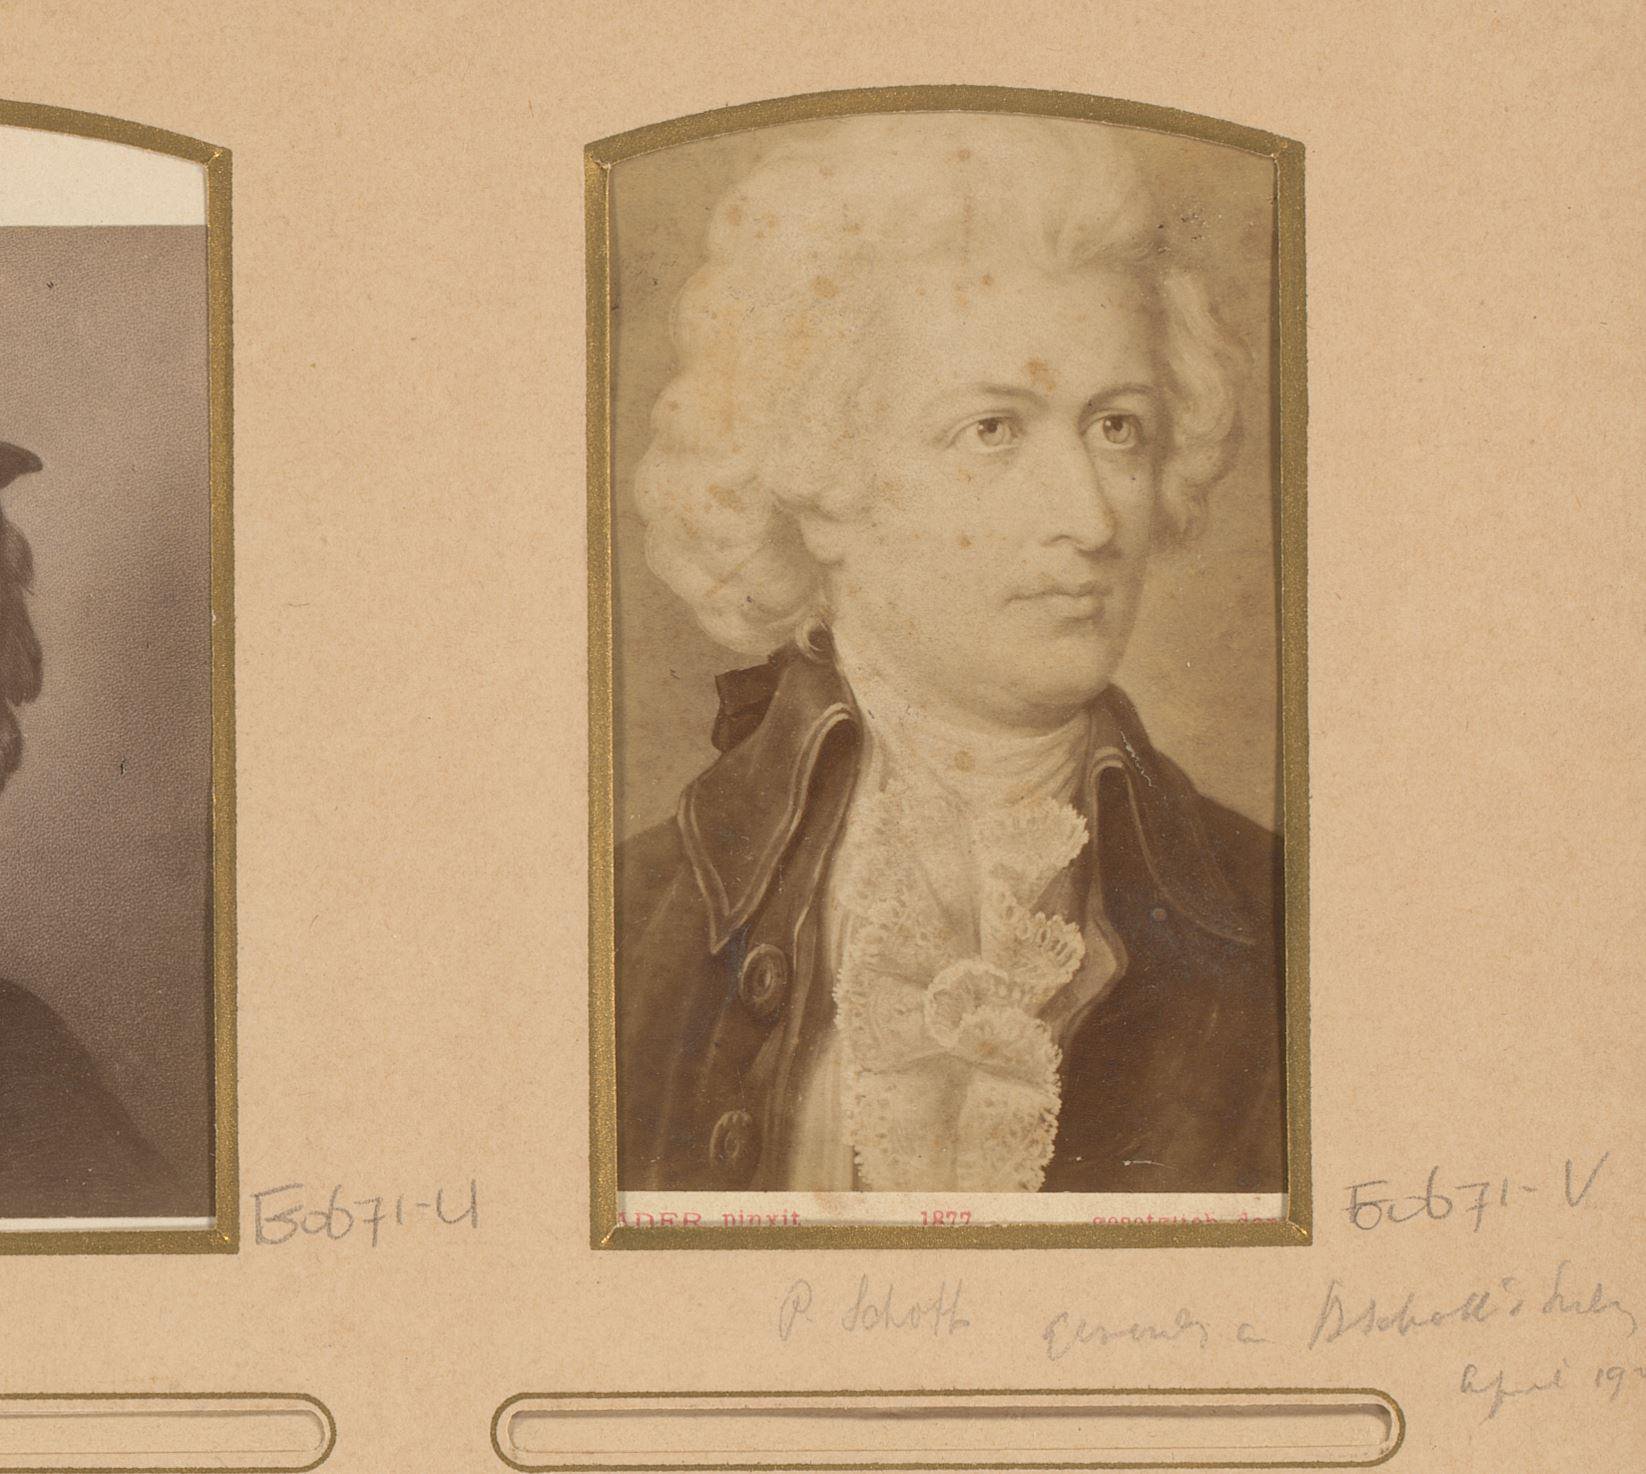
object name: reproduction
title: Fotoreproductie van een geschilderd portret van Wolfgang Amadeus Mozart door Ernst Hader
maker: sophus williams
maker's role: publisher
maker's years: 1835-1900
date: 1877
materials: cardboard, photographic support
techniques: albumen print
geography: berlin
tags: vienna, historical persons, portrait of composer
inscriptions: annotation: ‘P. Schott [...]’, inscription: ‘E. Hader pinxit/ 1877/ Gesetzlich geschützt/ Phot. u. Verlag v. Sophus Williams, Berlin W.’